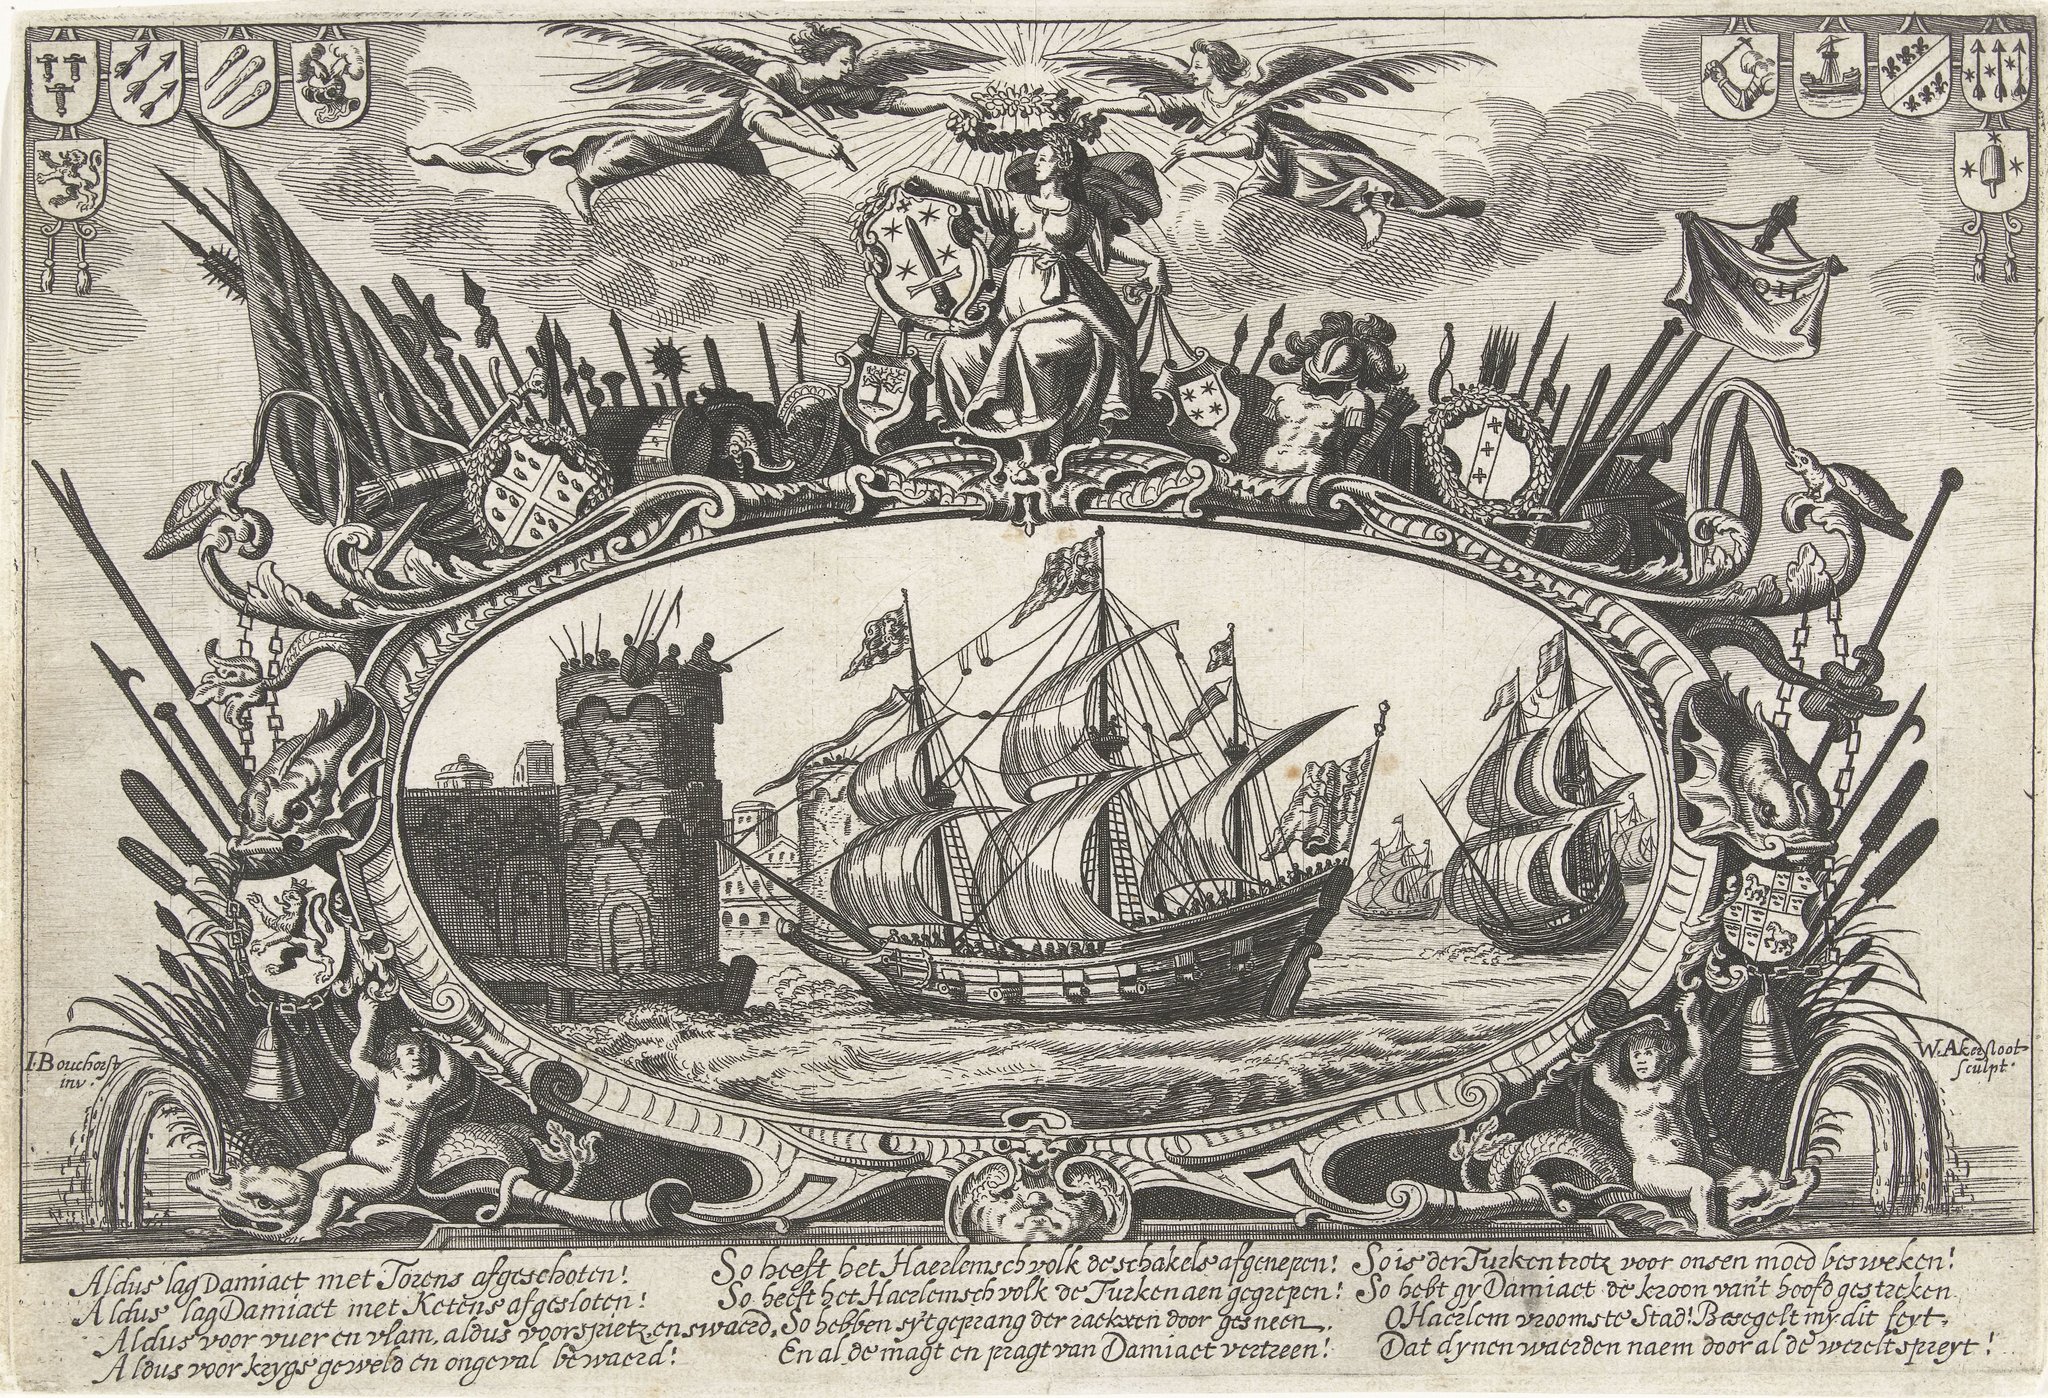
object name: history print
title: Beleg van Damiate, 1219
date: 1626-1628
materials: paper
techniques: engraving, etching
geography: haarlem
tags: haarlem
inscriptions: collector's mark: Lugt 2228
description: Het beleg van Damiate in 1219. Ovale voorstelling van de schepen voor de havens in omlijsting versierd met wapentuig, waterwezens en verschillende wapenschilden. Bovenaan de stedenmaagd van Haarlem met het wapen van Haarlem. Engelen houden haar een lauwerkrans boven het hoofd. In de bovenhoeken meer wapenschilden. Onder de voorstelling een vers in drie kolommen van elk vier regels: Aldus lag Damiaet met Torens afgeschoten! [...].